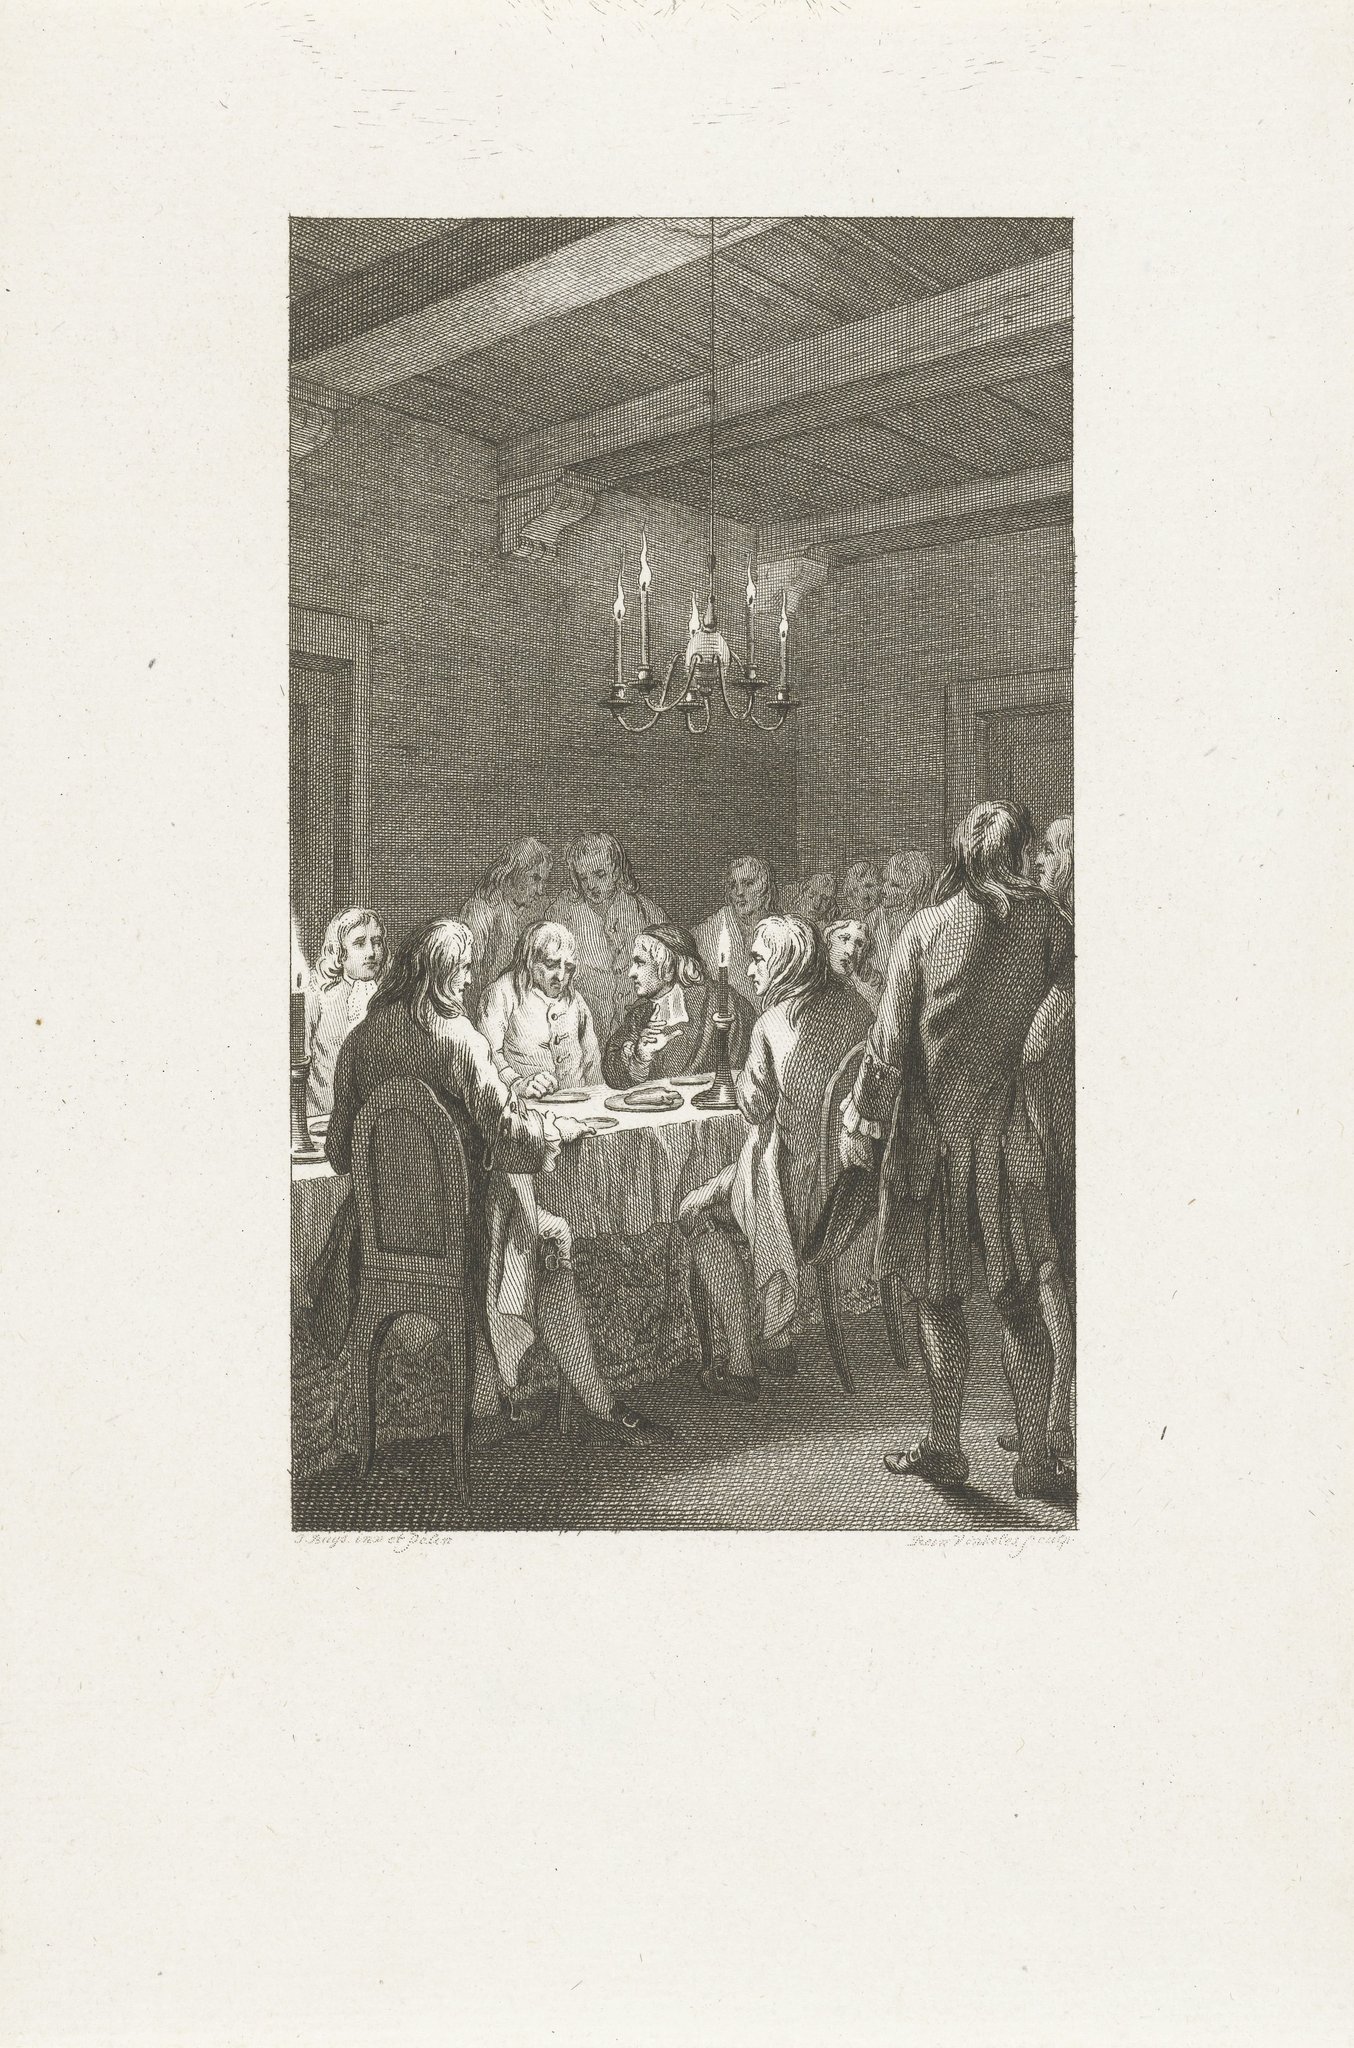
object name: print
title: Galgenmaal te Zierikzee, 1739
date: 1795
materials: paper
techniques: engraving, etching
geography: northern netherlands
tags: last hours before execution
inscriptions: collector's mark: Lugt 2228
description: Gebruikt als illustratie in: Jacobus Kok, Vaderlandsch Woordenboek, Johannes Allart, Amsterdam 1785-1799, 35 delen, dl. 34, pl. 4.